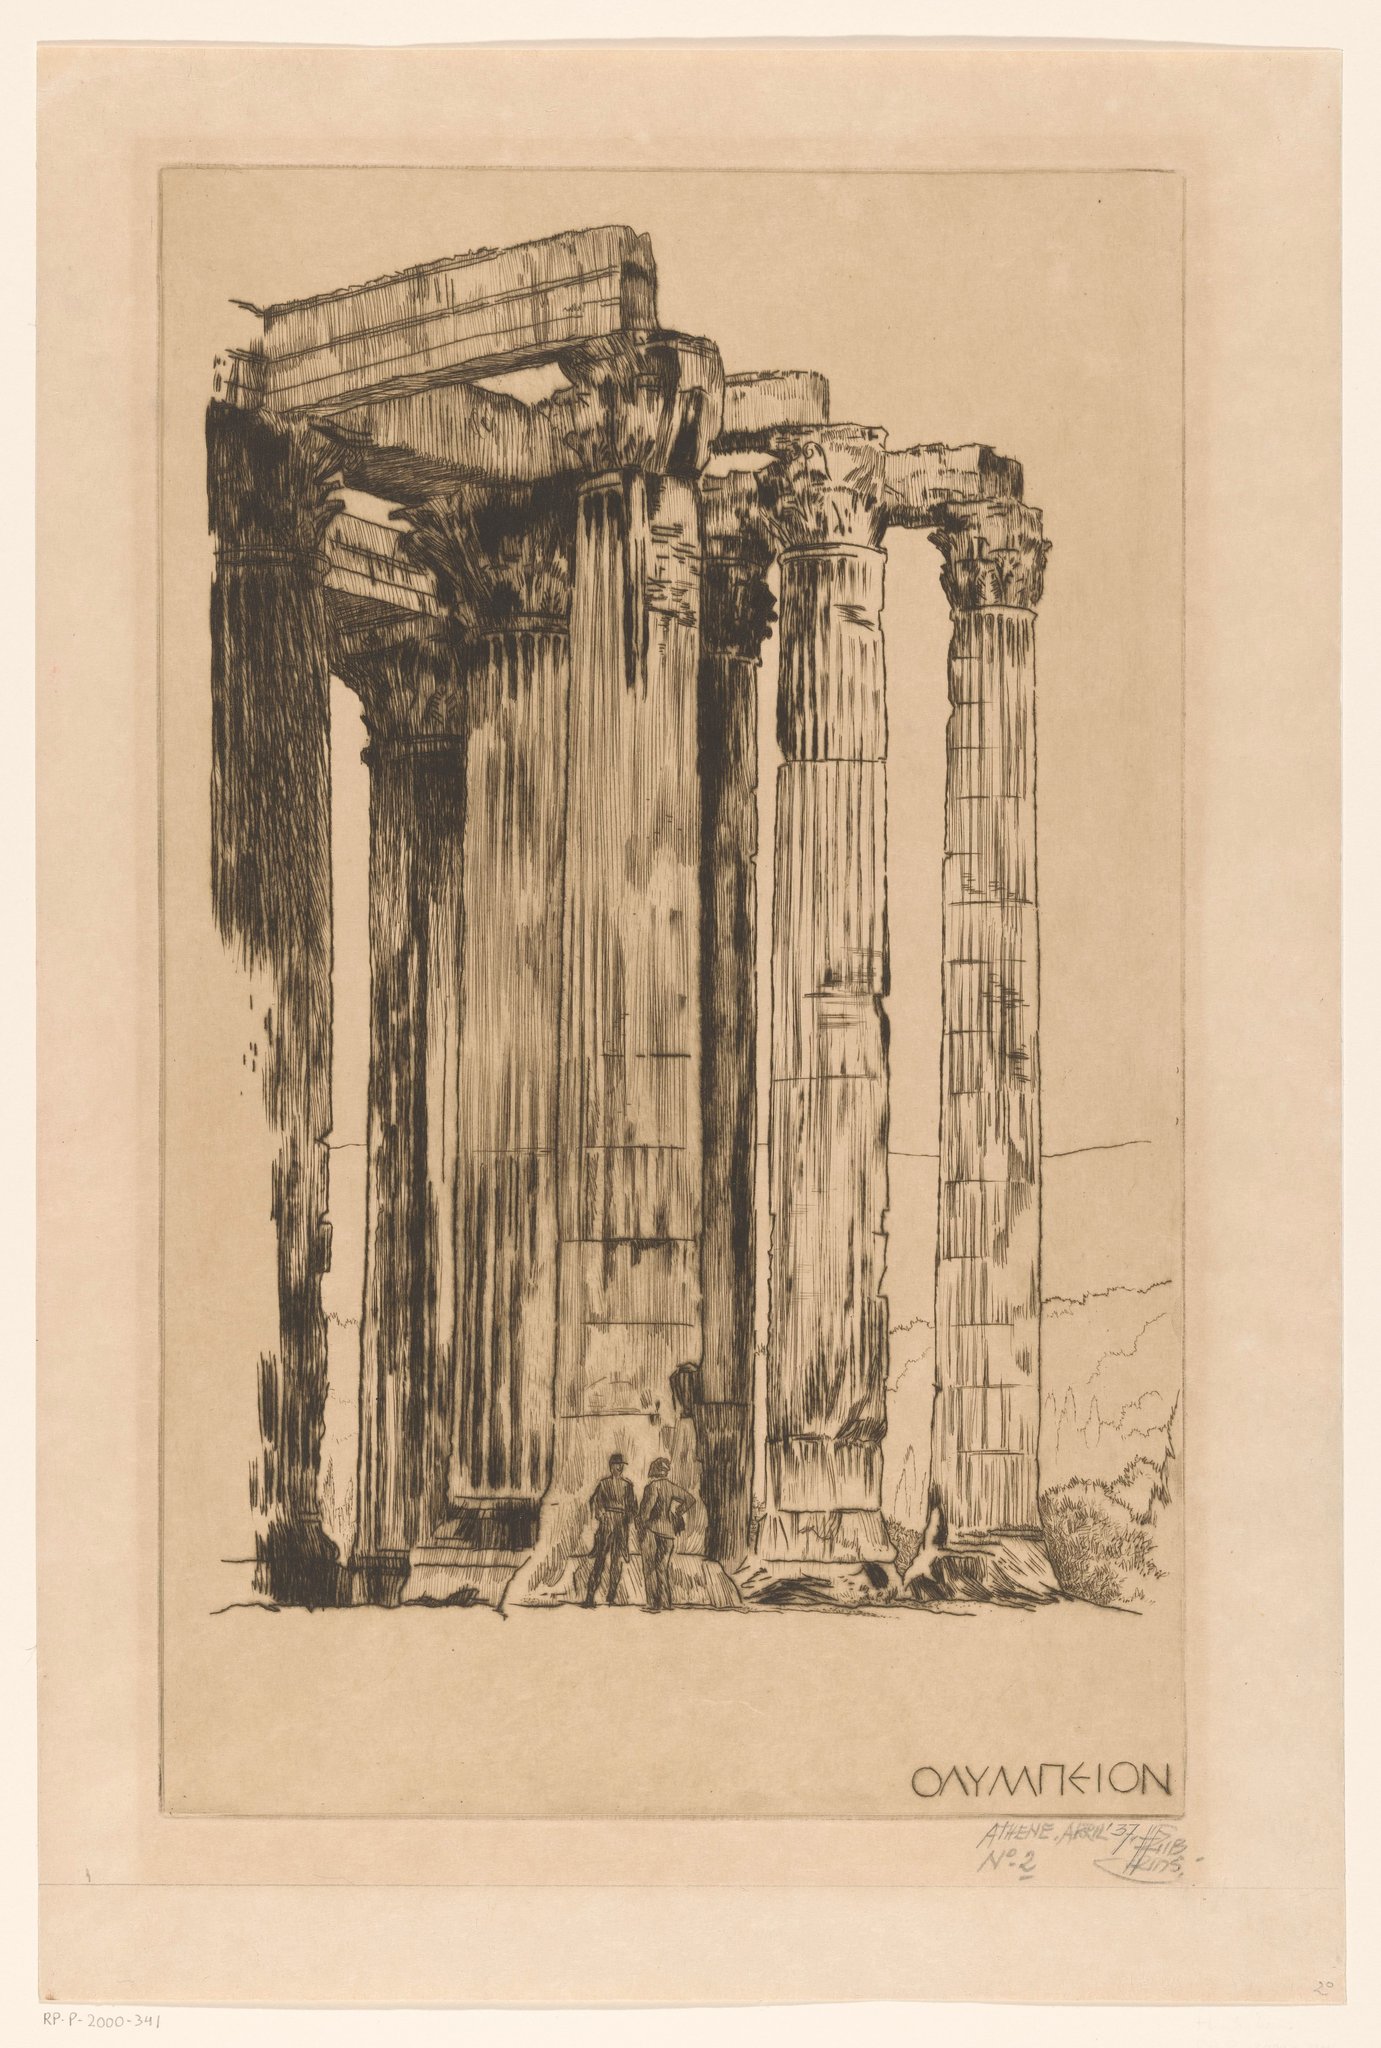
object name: print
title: Olympieion met twee mannen voor een zuil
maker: huib luns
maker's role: draughtsman, print maker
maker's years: 1881-1942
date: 1904-1937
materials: paper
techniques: etching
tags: temple, shrine ~ greek religion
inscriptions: collector's mark: Lugt 2228, collector's mark: ‘P. Jh.’, collector's mark: Lugt 2760, number: ‘No. 2’